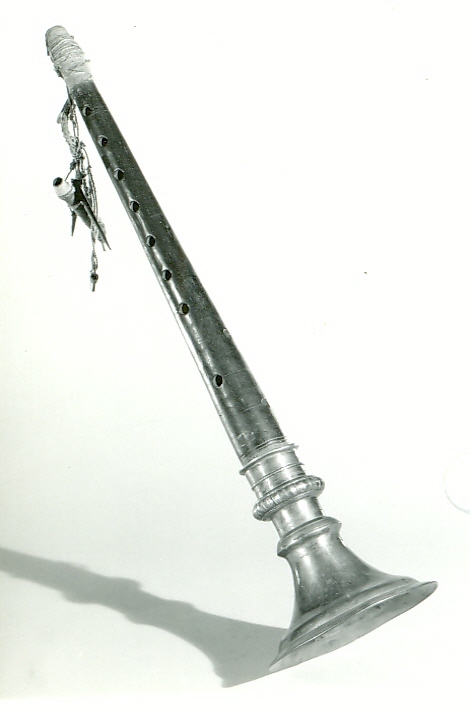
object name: nāgasvaram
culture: indian, south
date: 1867-1900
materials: metal, wood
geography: india